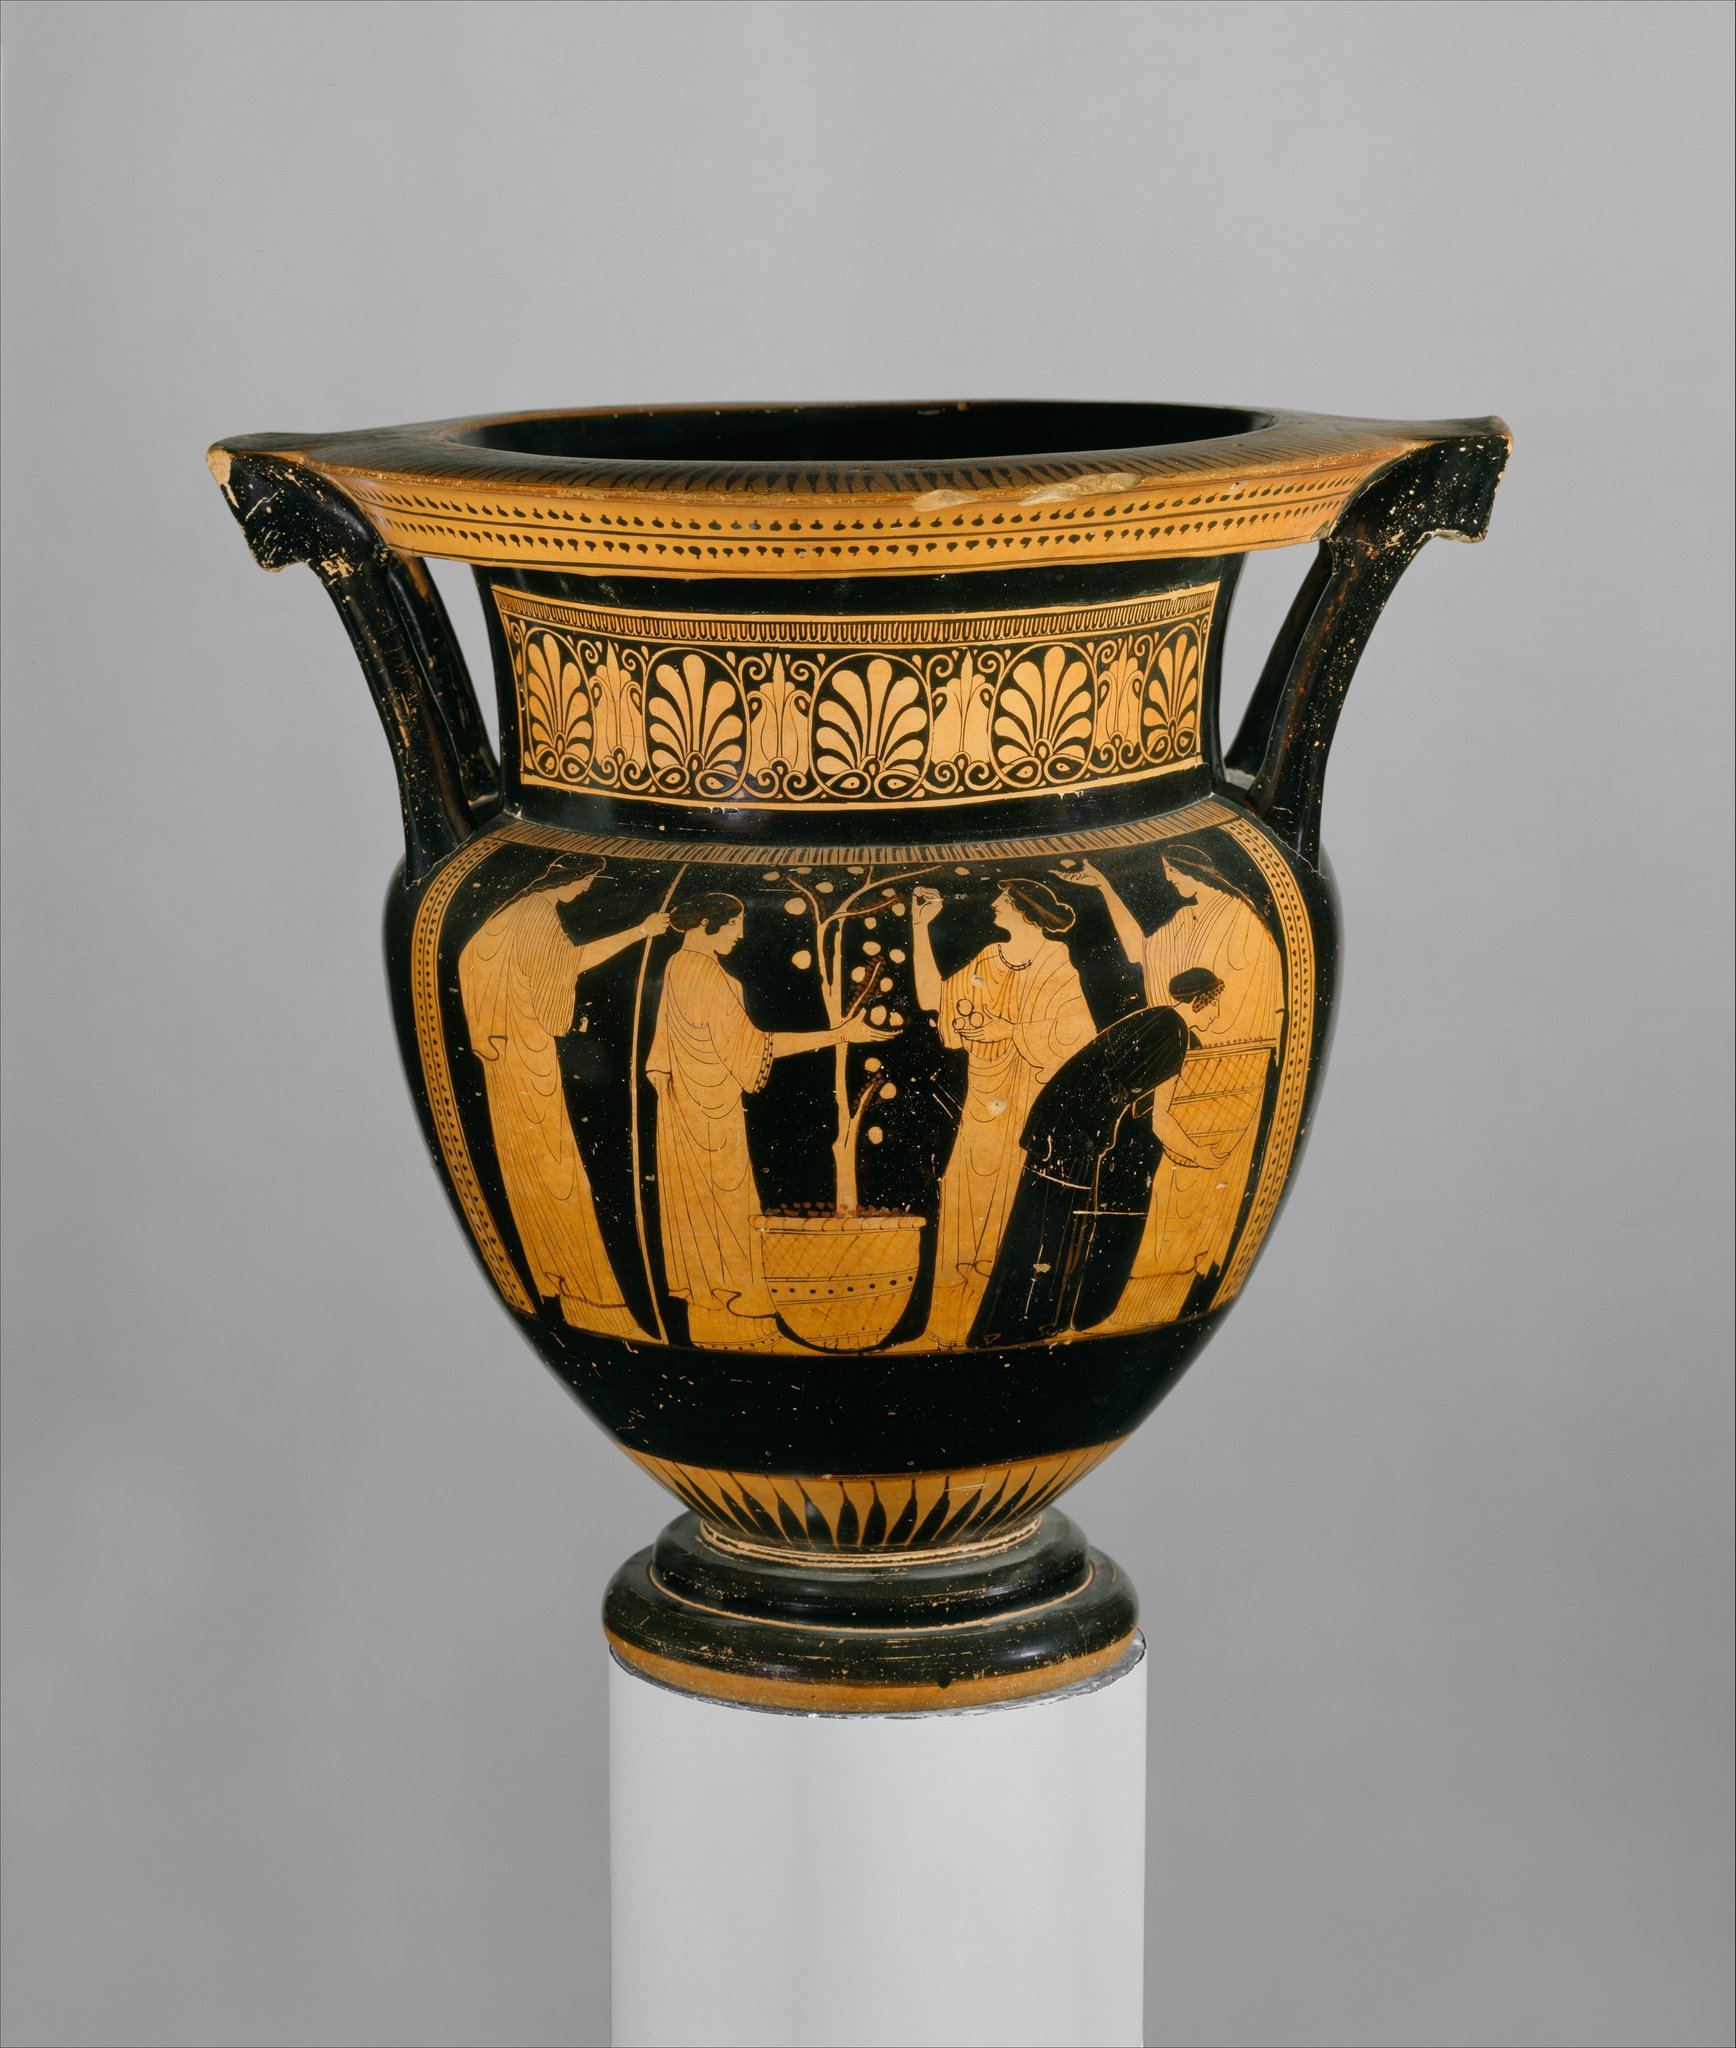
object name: column krater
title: Terracotta column-krater (bowl for mixing wine and water)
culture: greek, attic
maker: orchard painter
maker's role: artist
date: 460 BCE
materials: terracotta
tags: apples,men,women